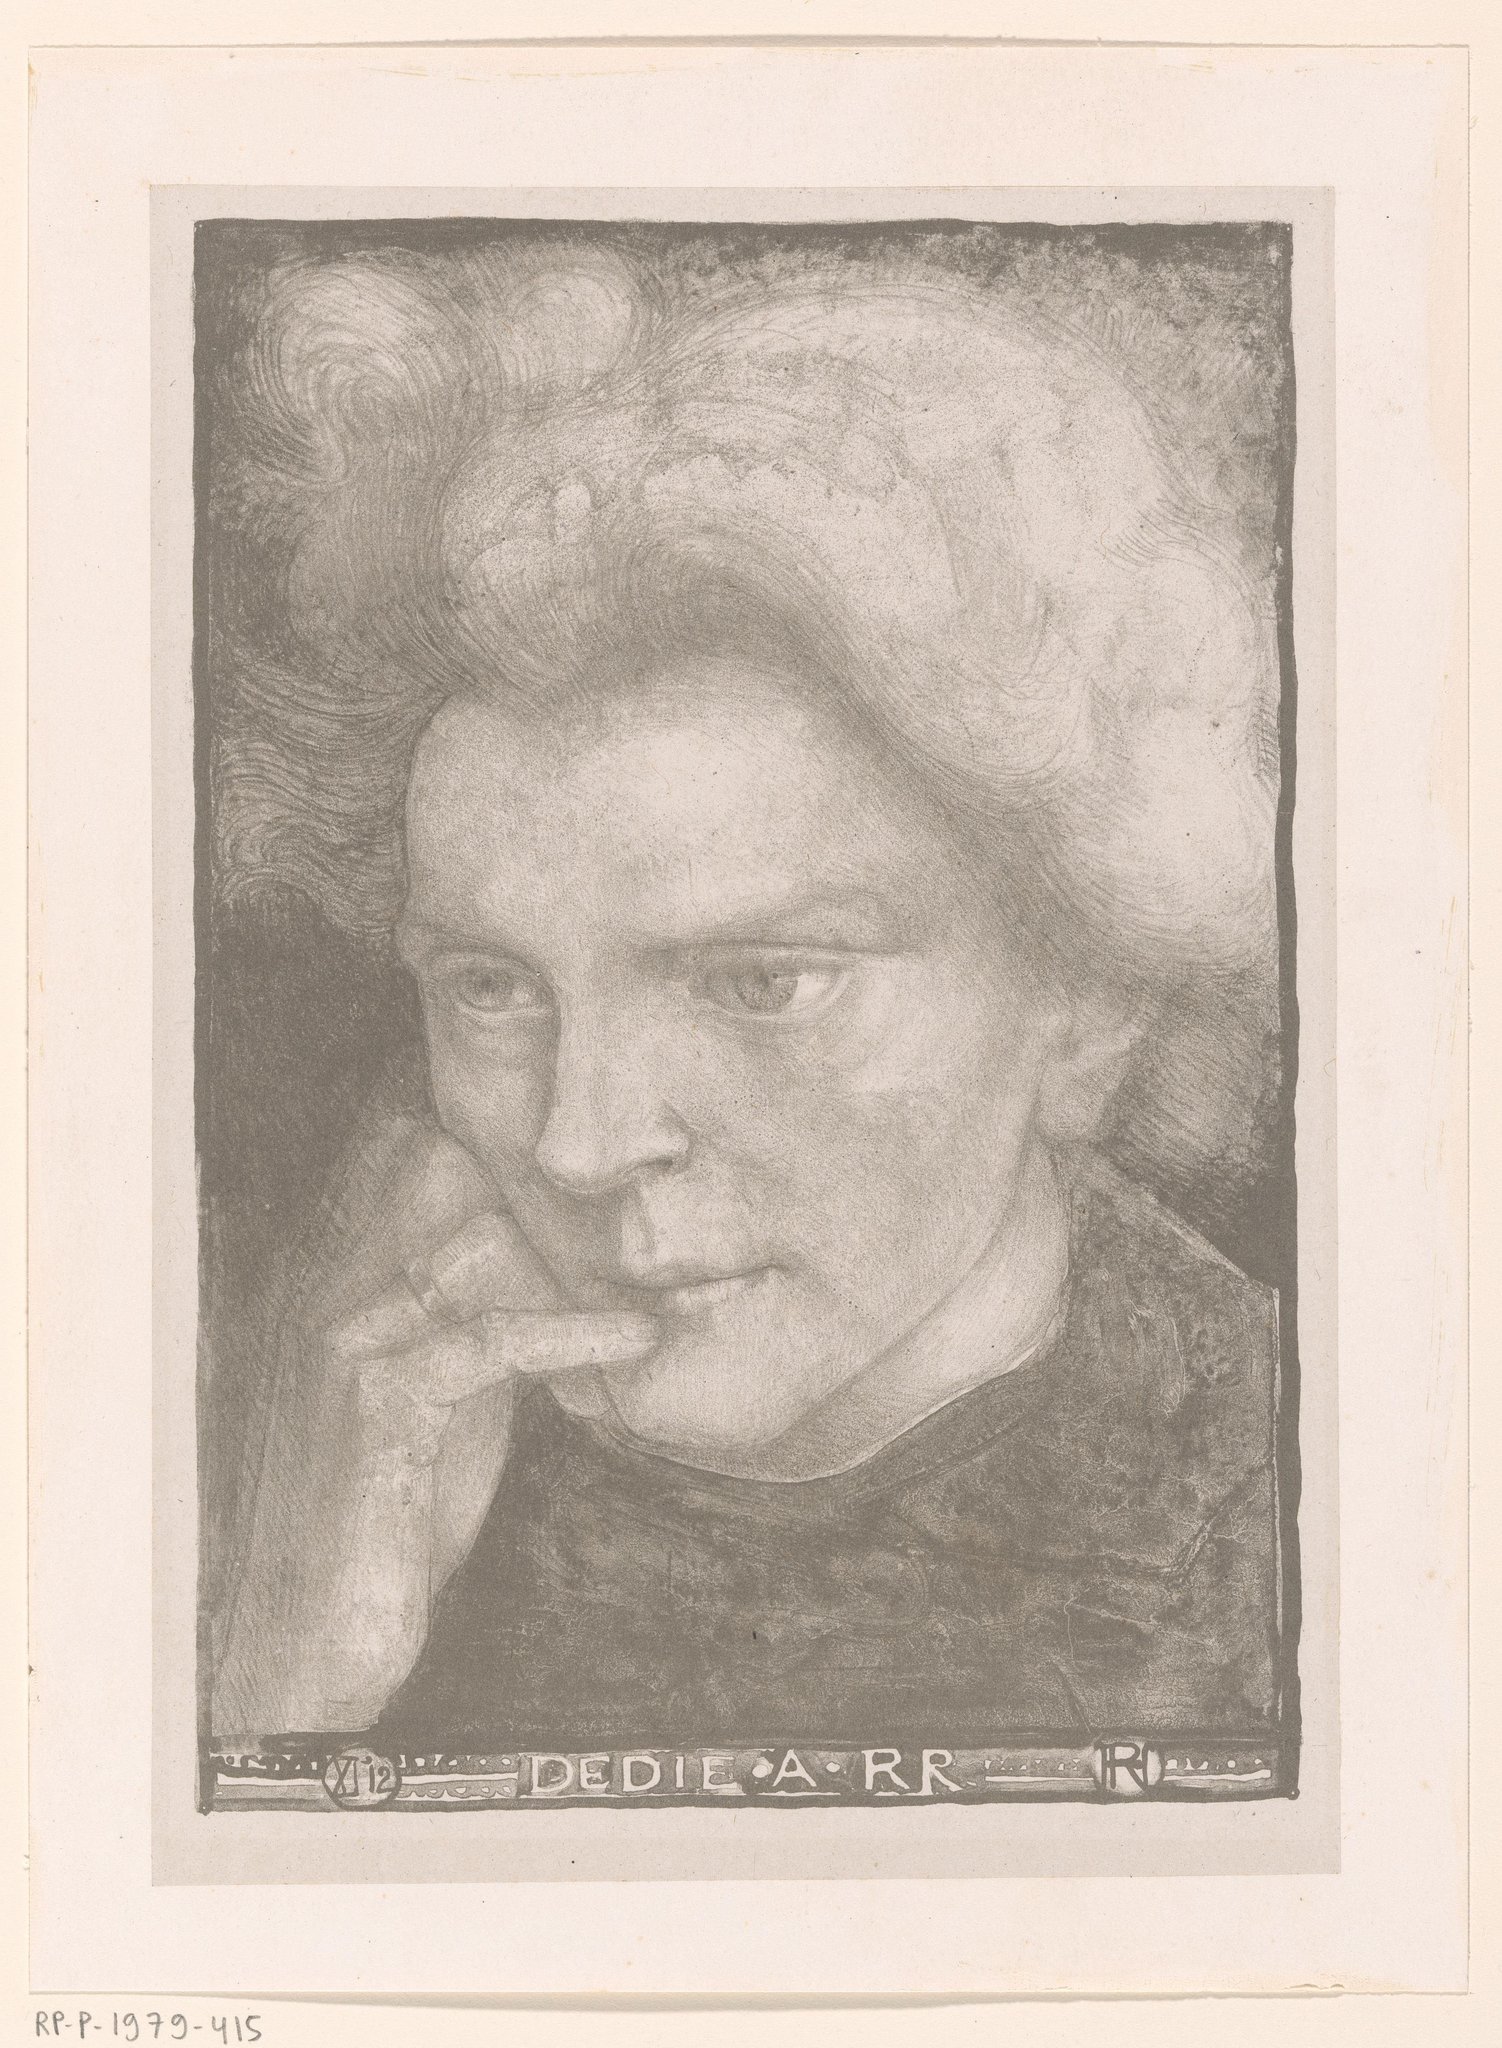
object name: print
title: Portret van een onbekende vrouw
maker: richard nicolaüs roland holst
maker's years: 1868-1938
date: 1911-1912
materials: paper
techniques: lithograph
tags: hand(s) bent towards the head, anonymous historical person portrayed - bb - woman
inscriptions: collector's mark: Lugt 2228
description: De vrouw ondersteunt haar hoofd met haar hand.